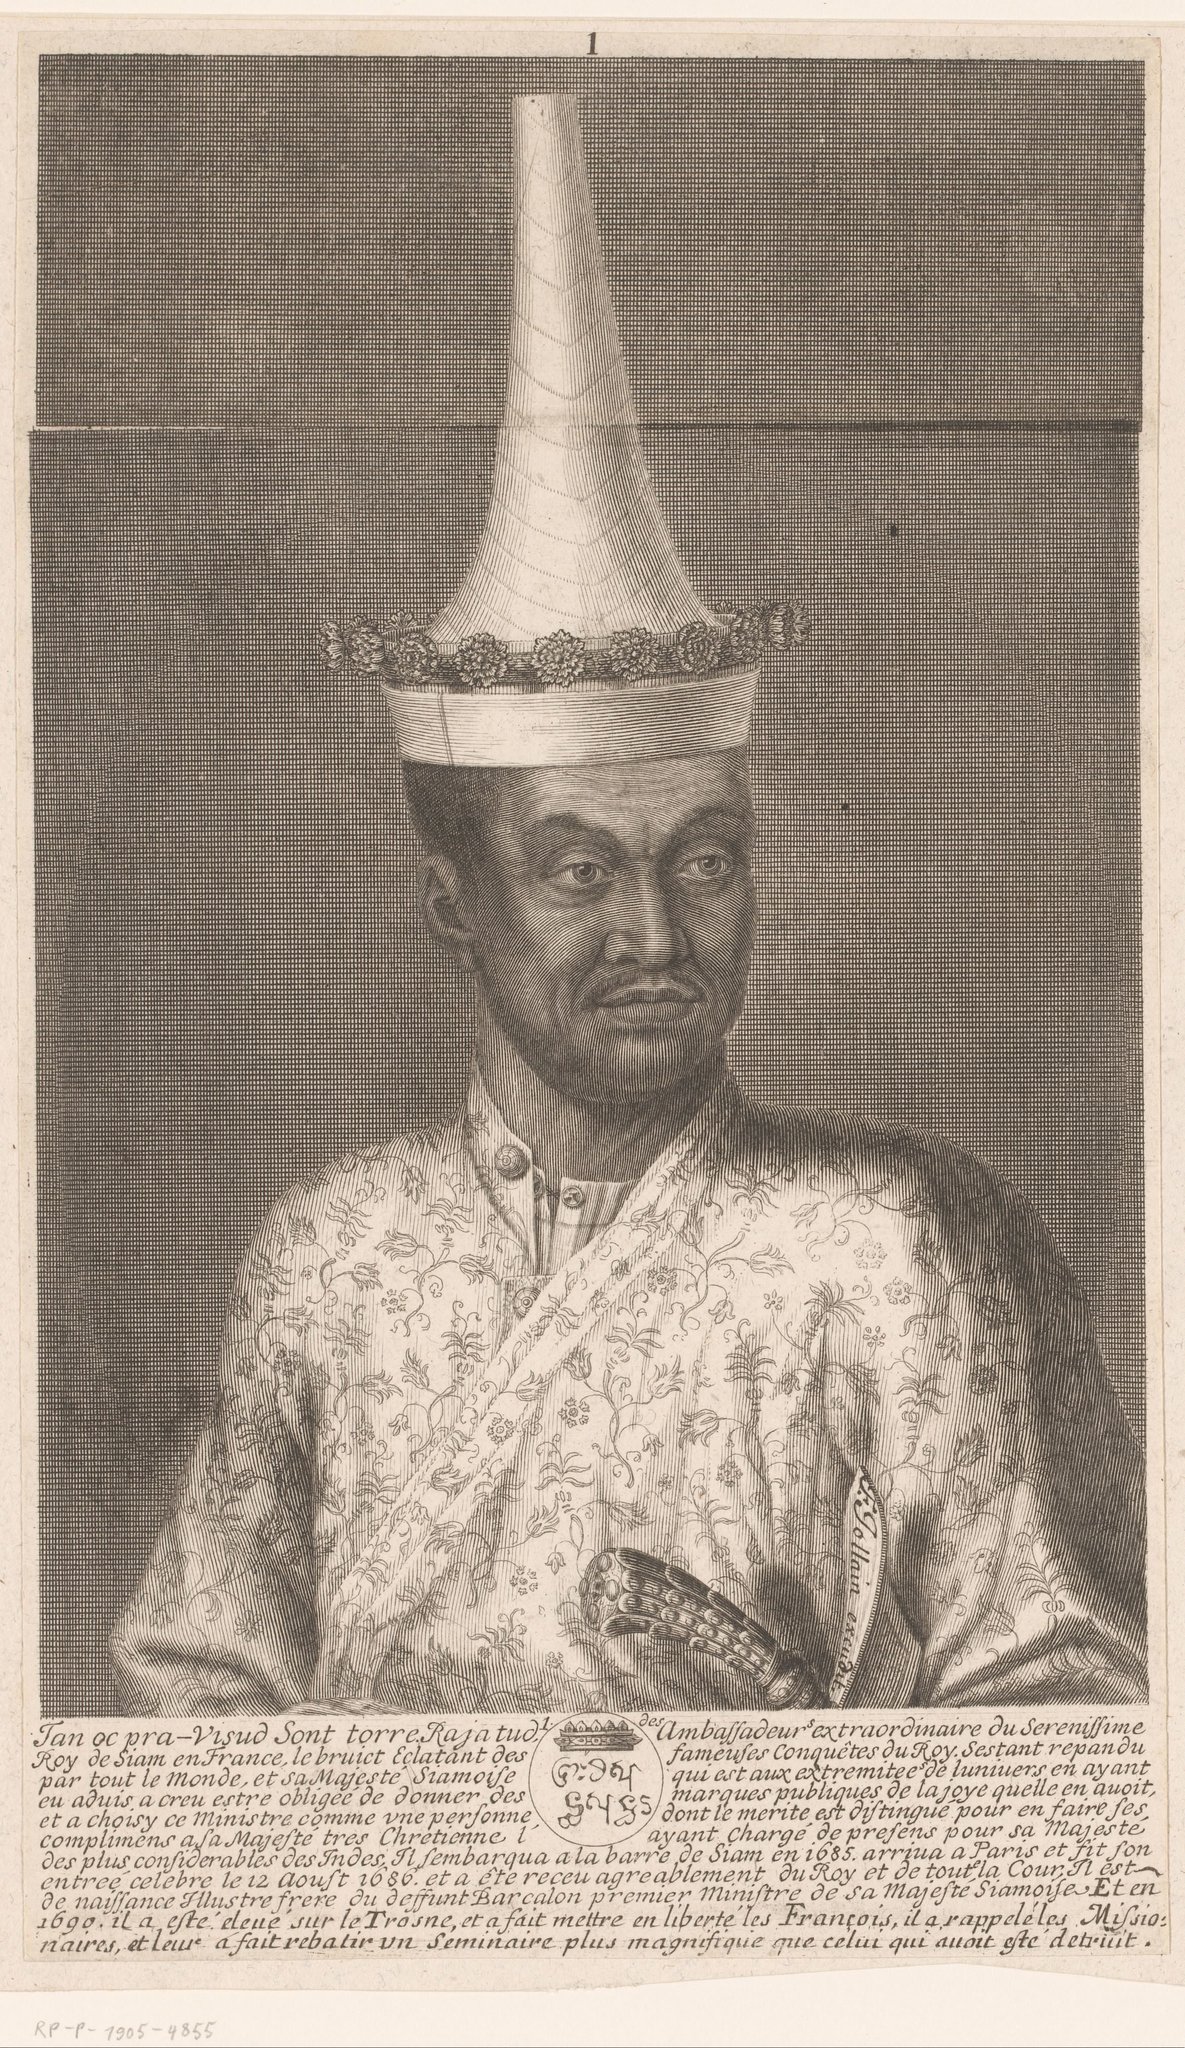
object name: print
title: Portret van Tan oc pra-Visud Sont torre Raja tud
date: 1651-1704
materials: paper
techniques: engraving, etching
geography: france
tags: historical persons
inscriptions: collector's mark: Lugt 2228